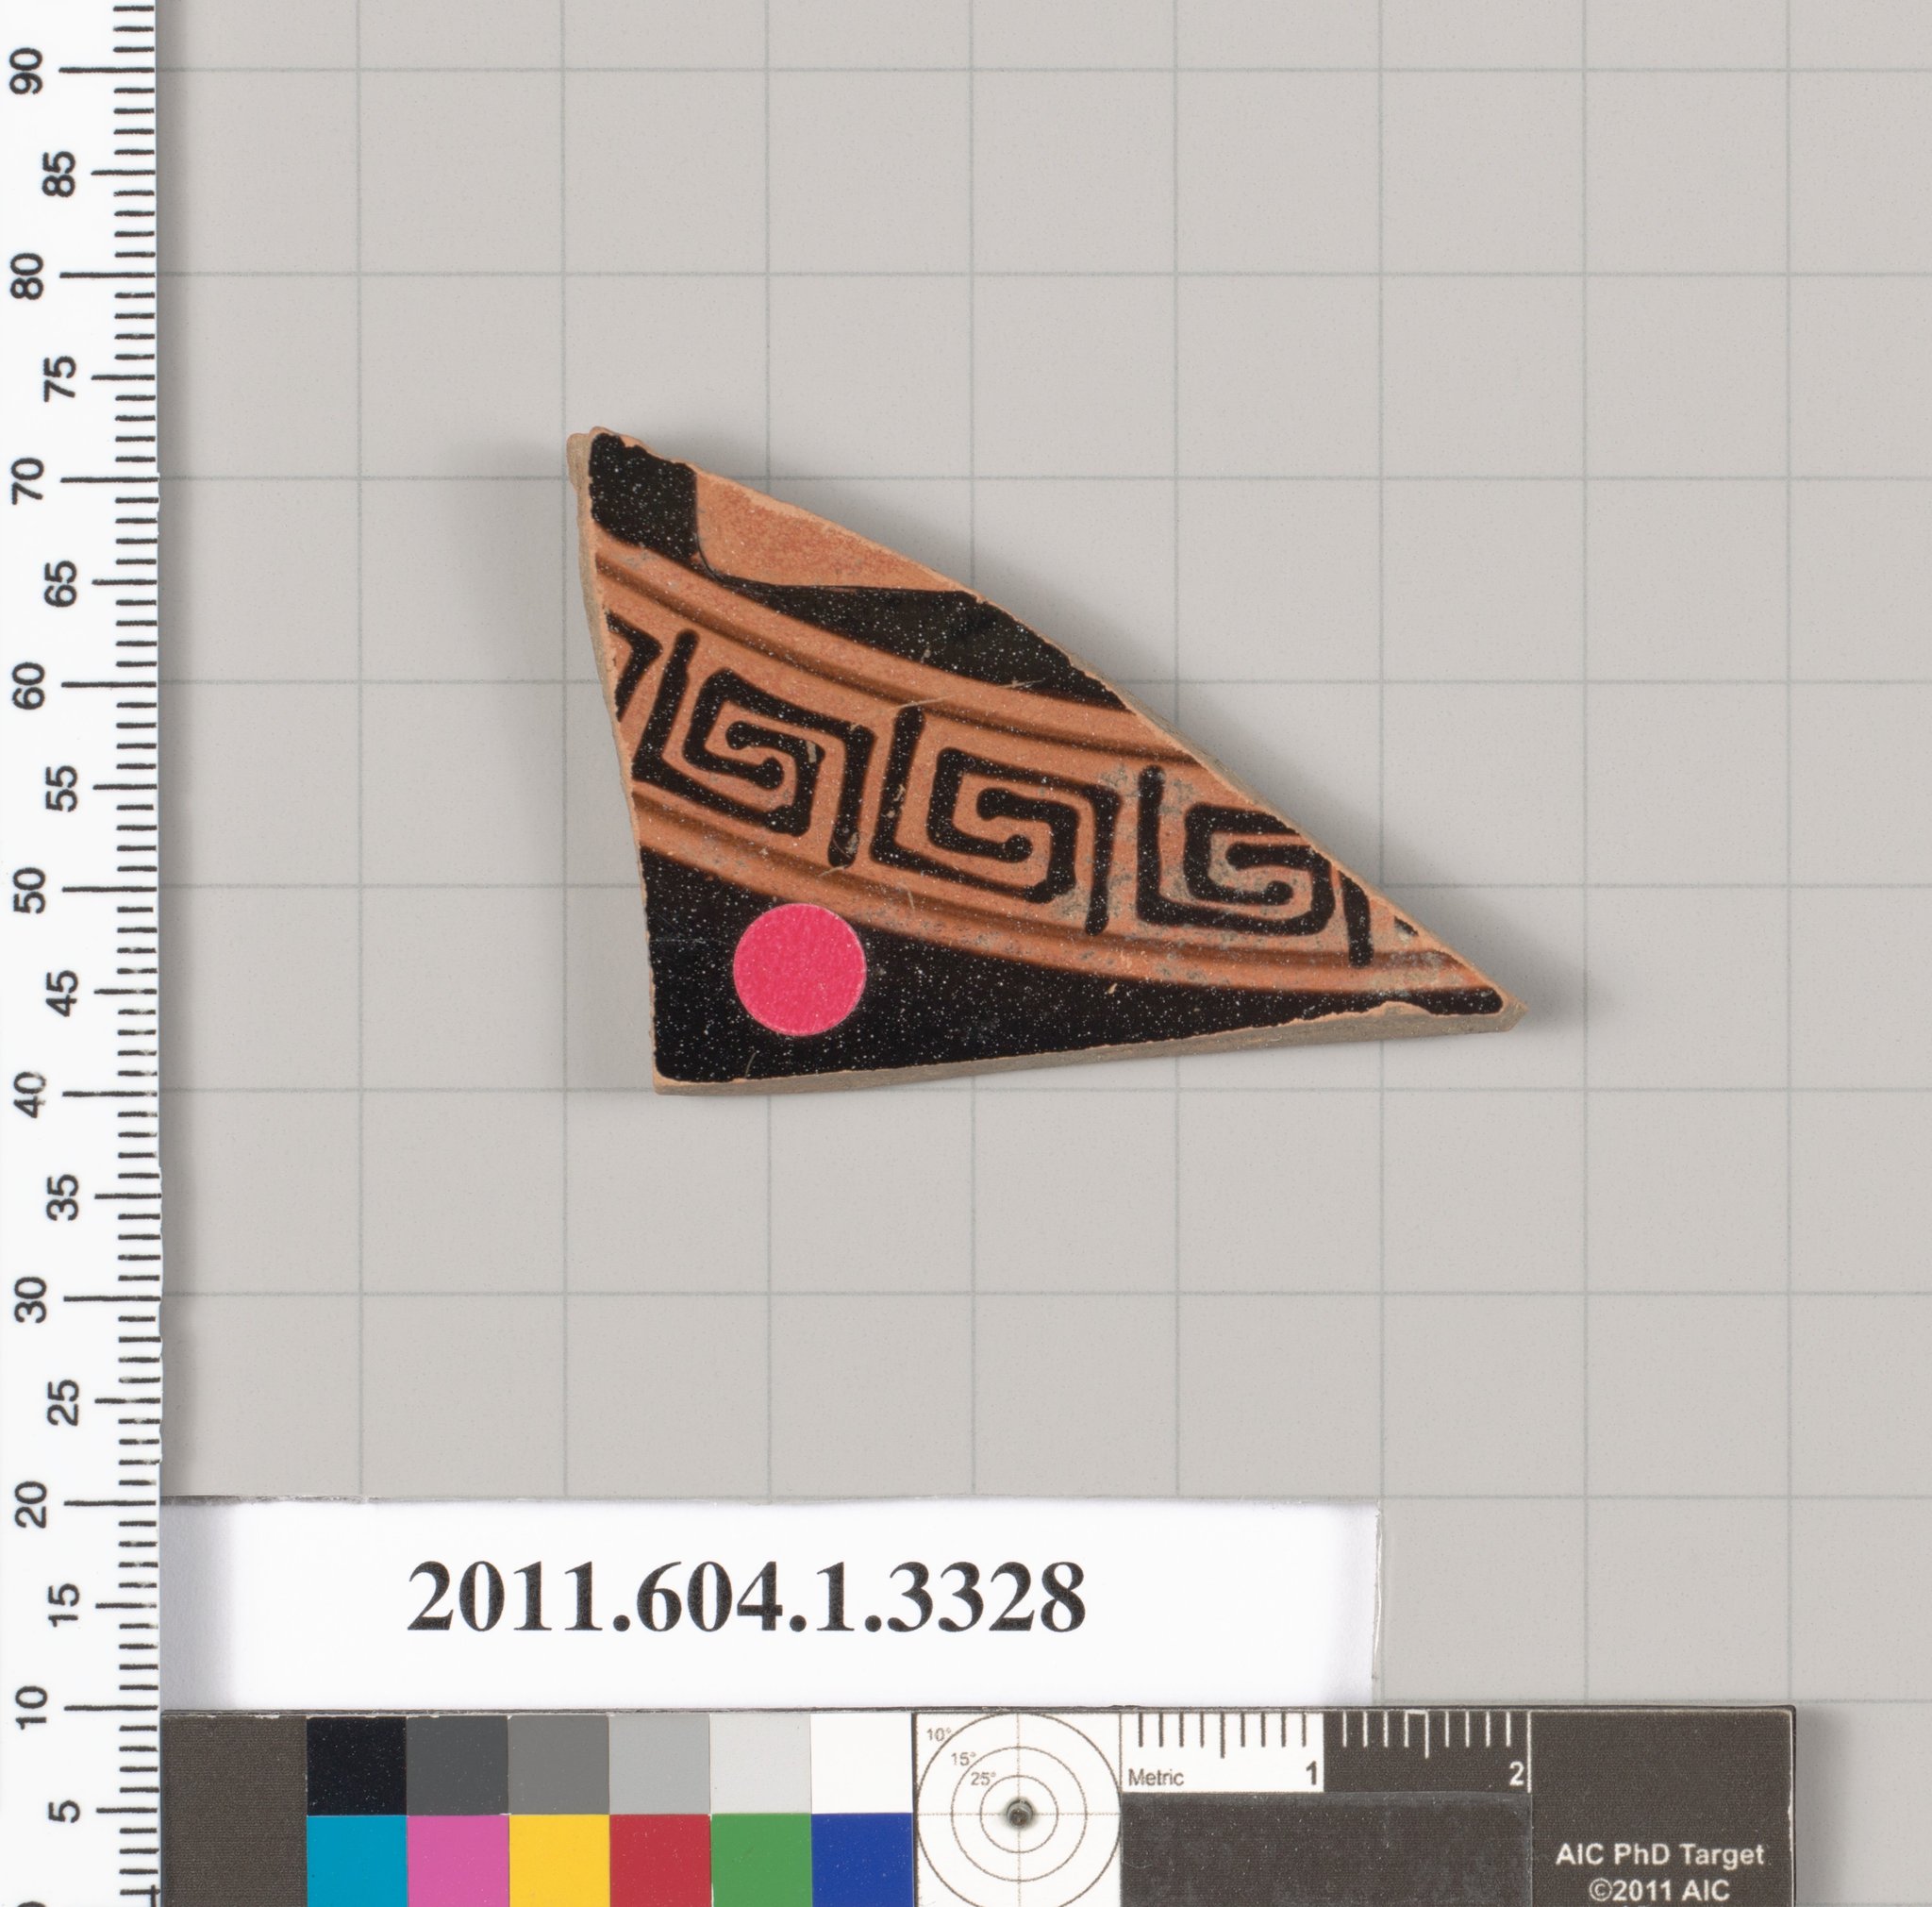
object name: kylix fragment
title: Terracotta fragment of a kylix (drinking cup)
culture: greek, attic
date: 500-476 BCE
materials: terracotta